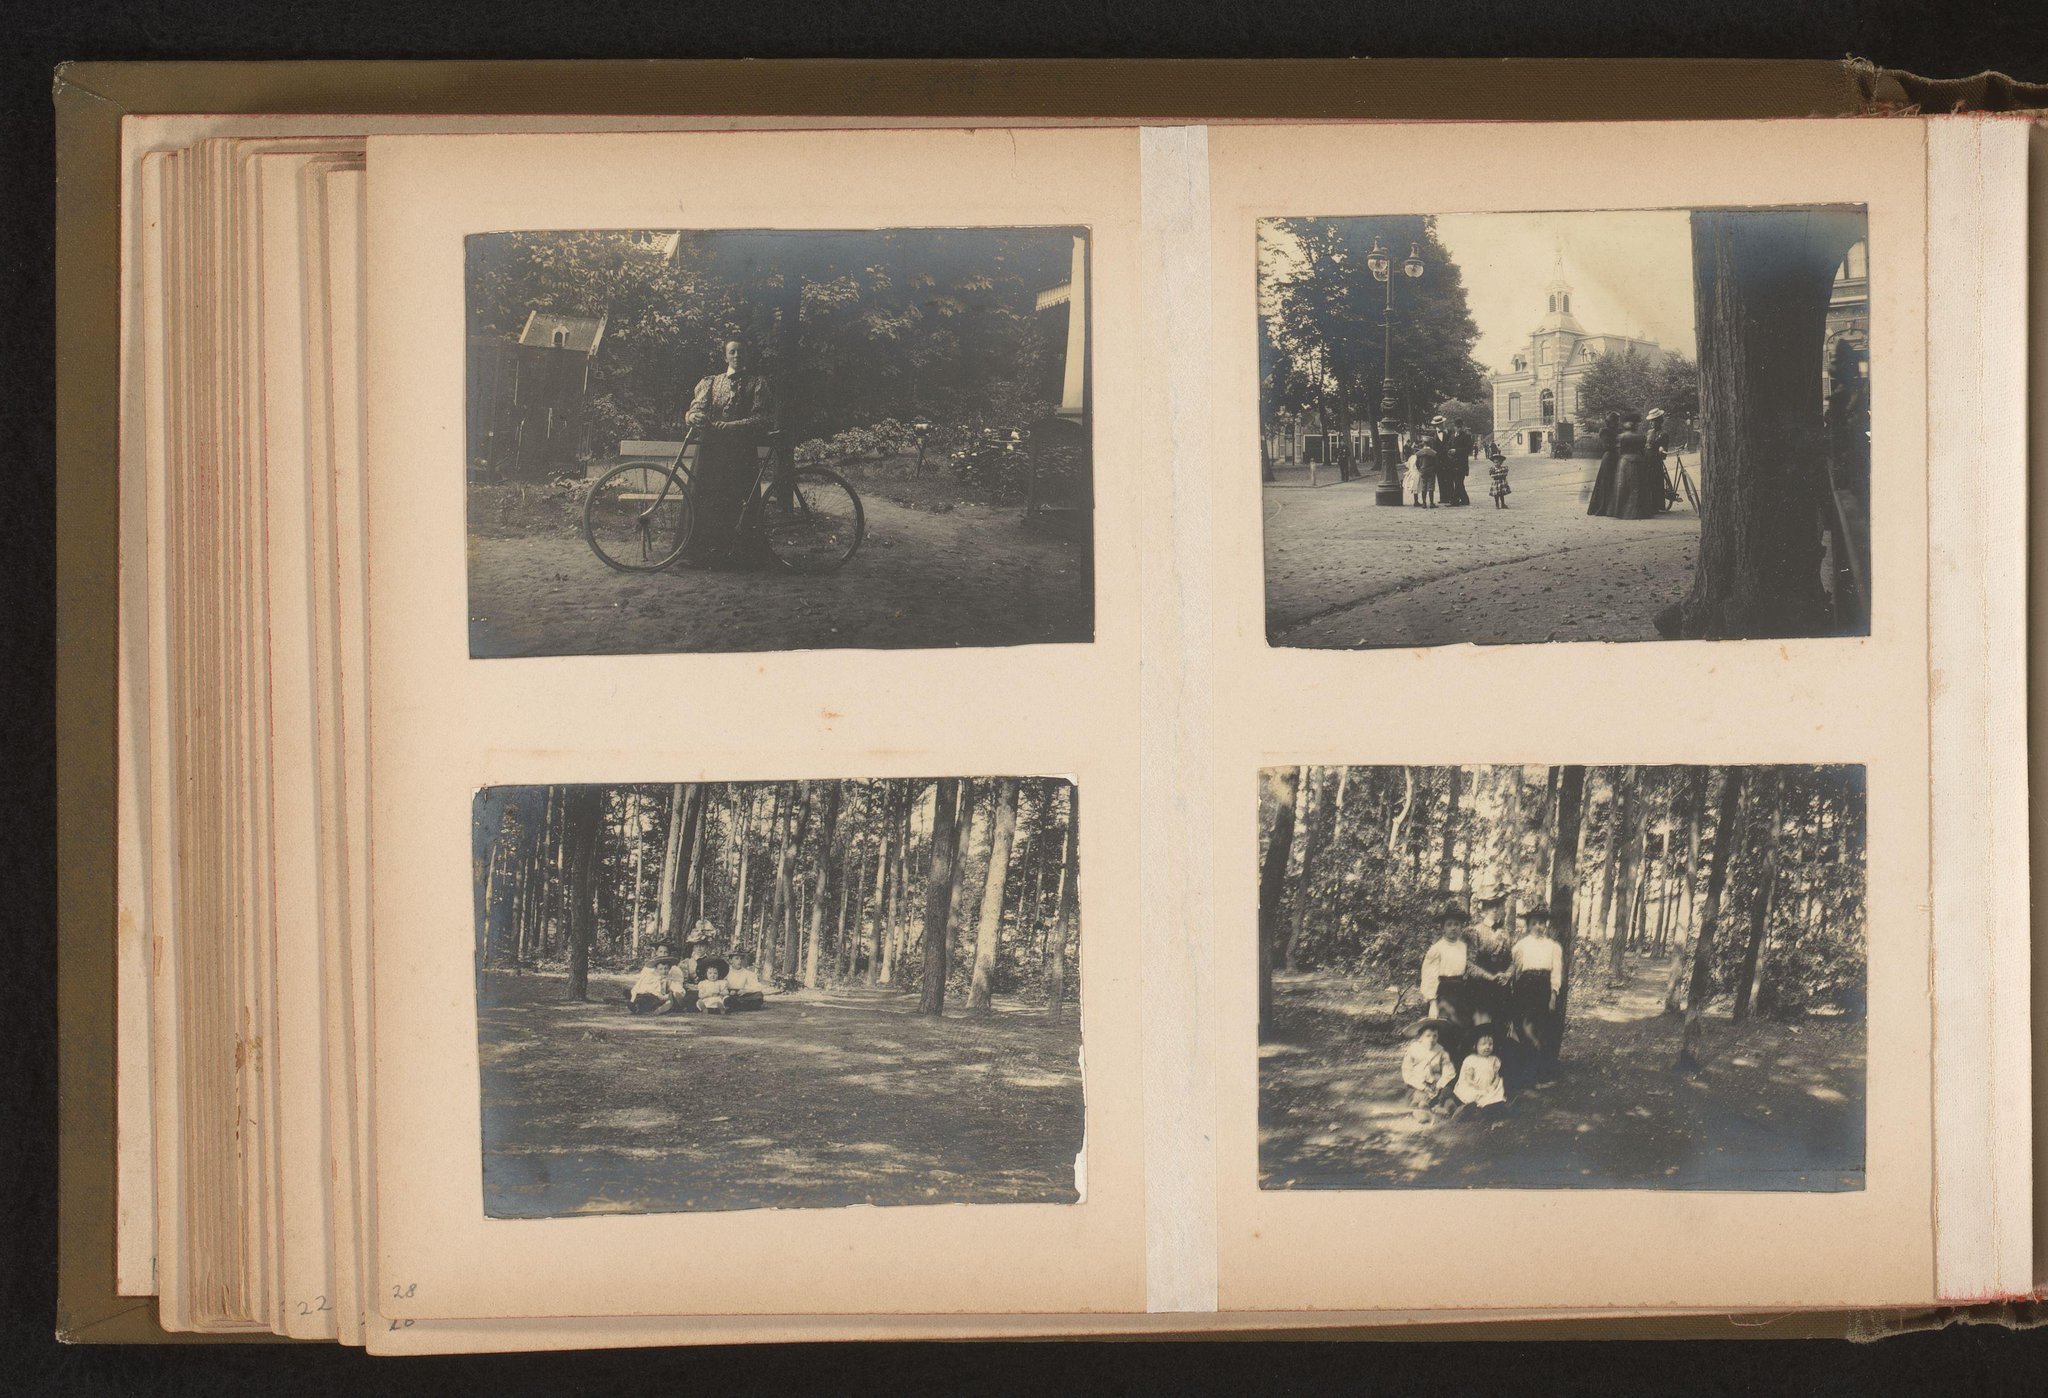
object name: photograph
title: Vier foto's van vrouwen en kinderen in een bos en een dorp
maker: Anonymous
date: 1895-1910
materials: paper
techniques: gelatin silver print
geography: netherlands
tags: village, forest, wood, bicycle, mother and child(ren), woman and child(ren) (family group), netherlands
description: Deze foto's maken deel uit van een album.